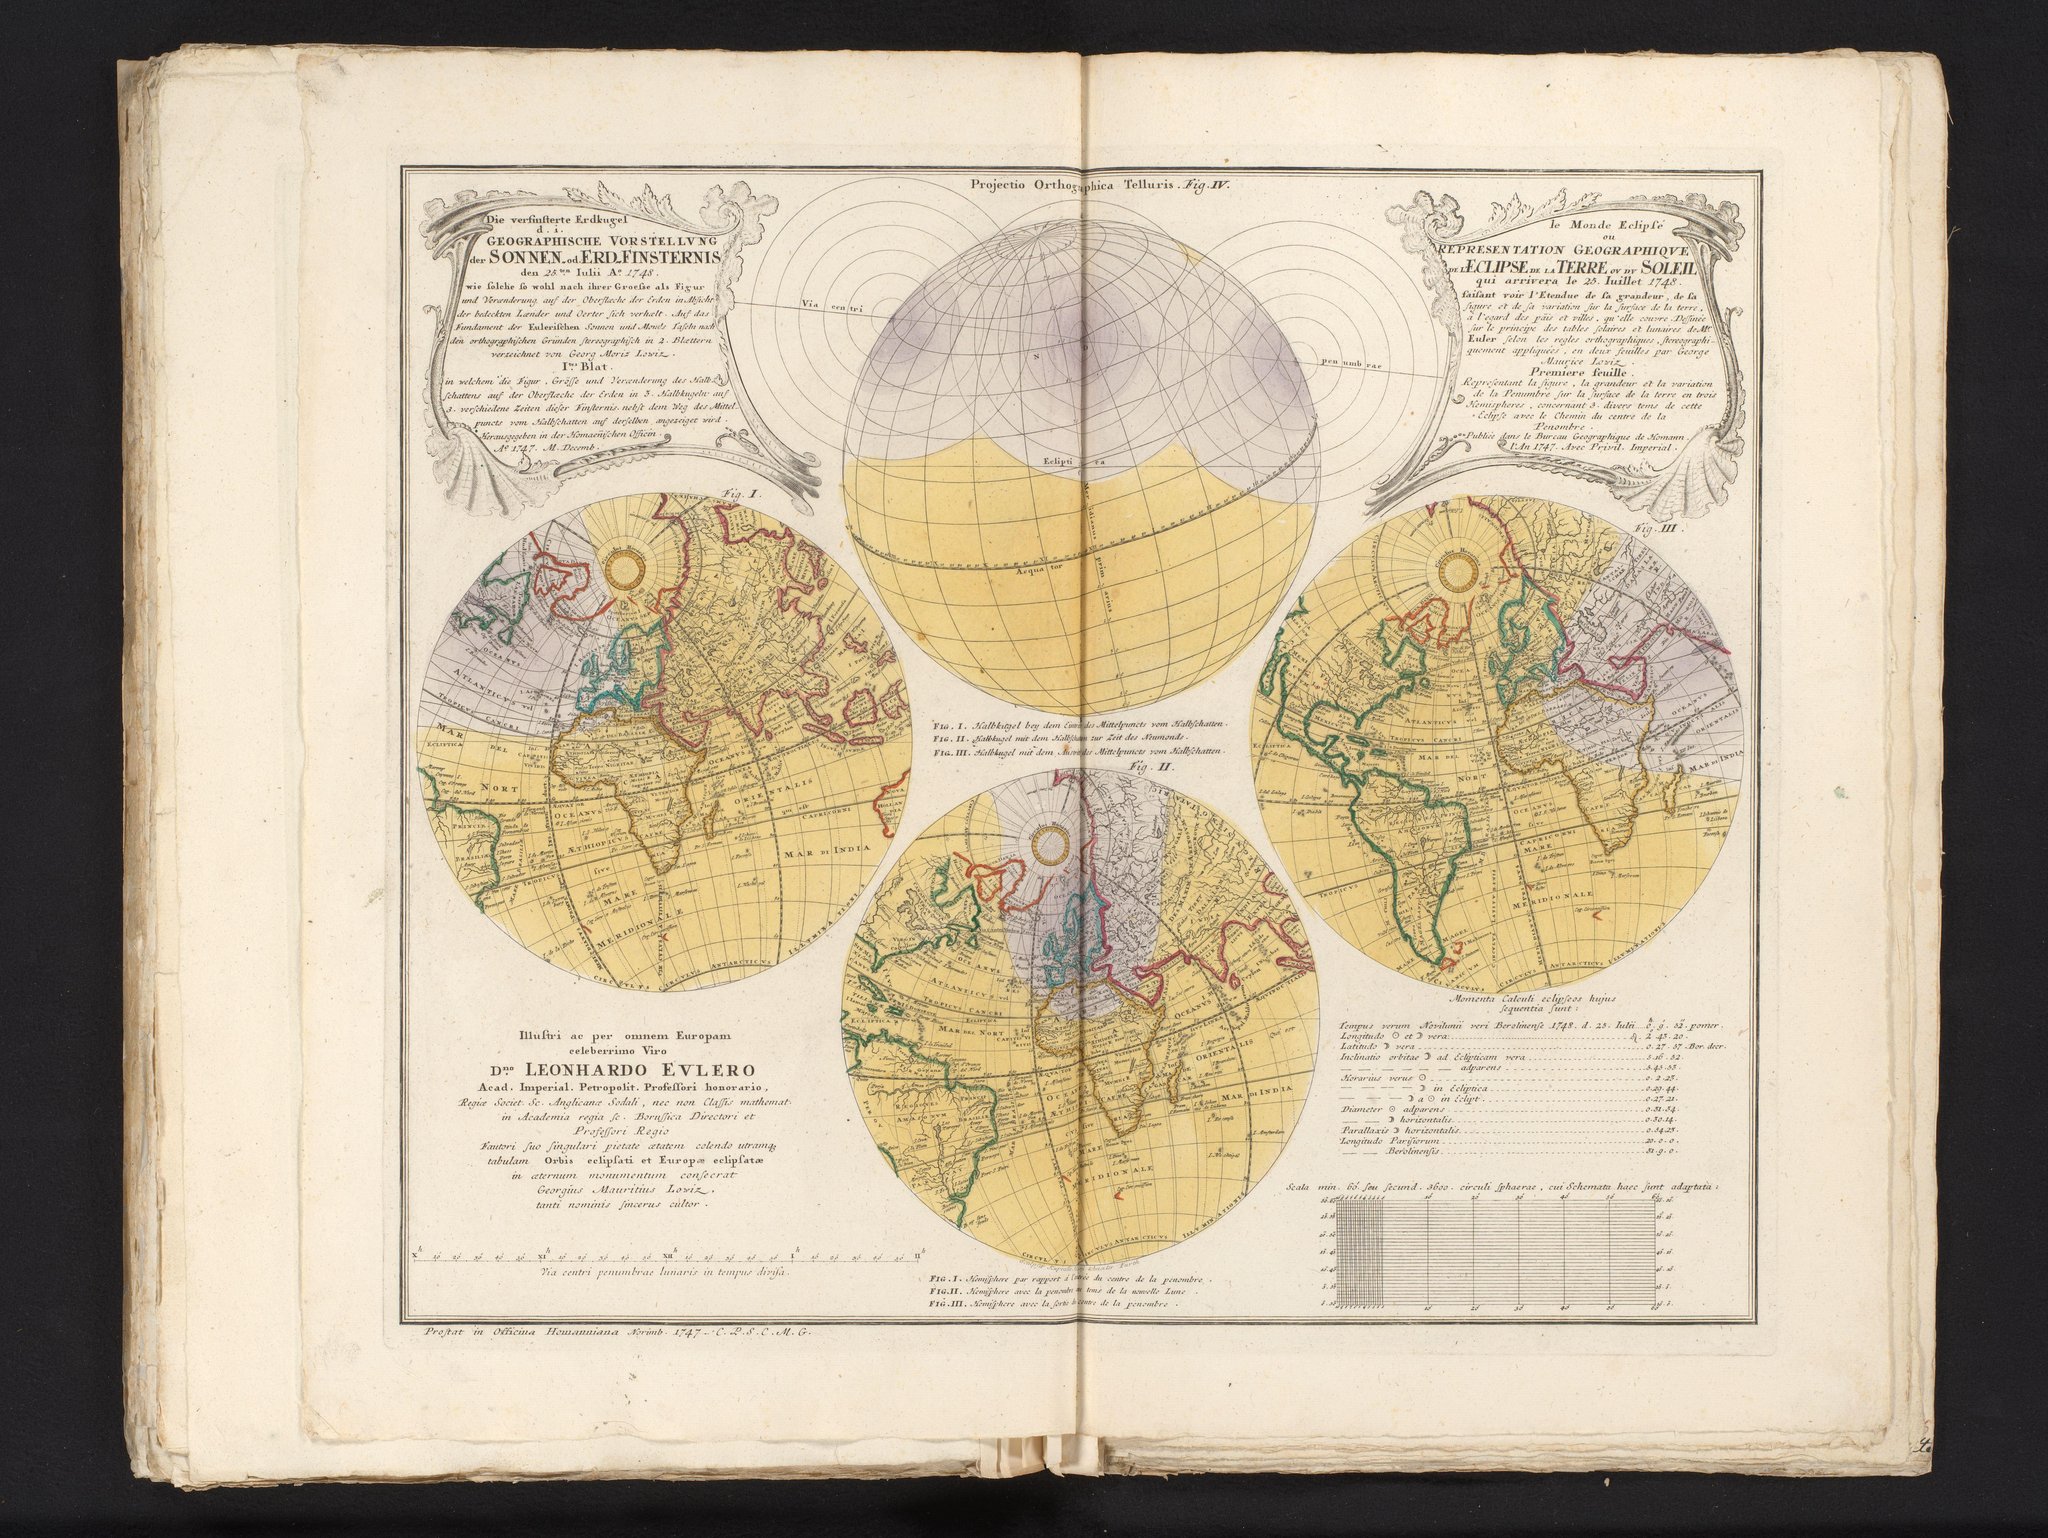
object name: print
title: Die verfinsterte erdkugel d.i. geographische vorstellung der sonnen (...) / Le monde eclipsé ou representation geographique de l'eclipse (...)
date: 1747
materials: paper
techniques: engraving, etching, hand coloring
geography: nuremberg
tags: solar eclipse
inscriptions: date